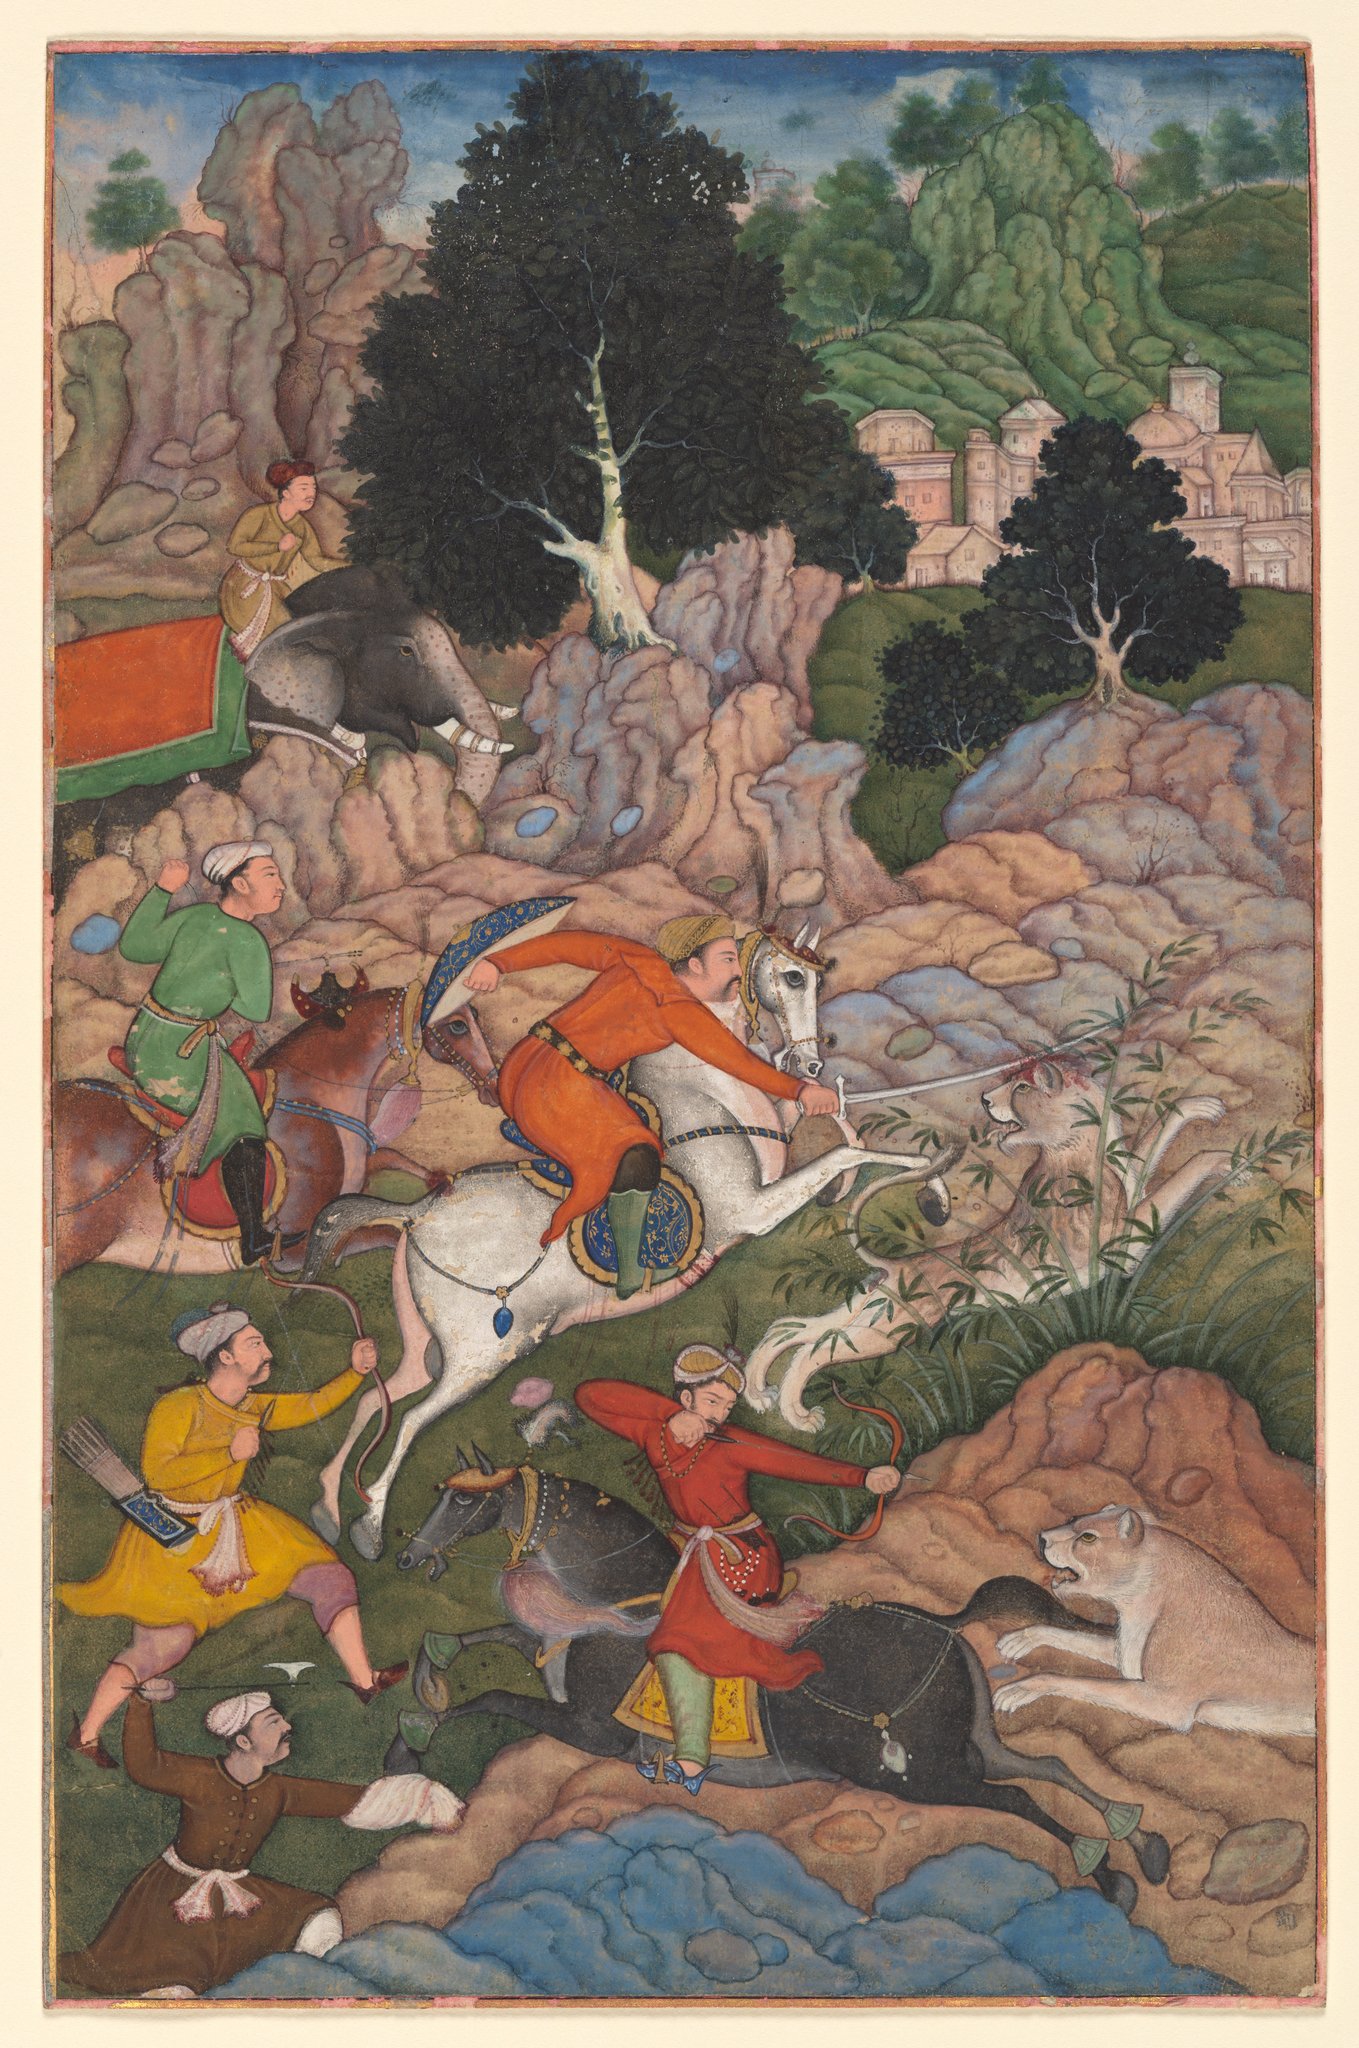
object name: folio from an illustrated manuscript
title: "Akbar Hunting", Folio from an Akbarnama (History of Akbar)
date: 1567-1600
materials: gold, ink, paper, watercolor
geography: pakistan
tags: men,hunting,elephants,horses,lions